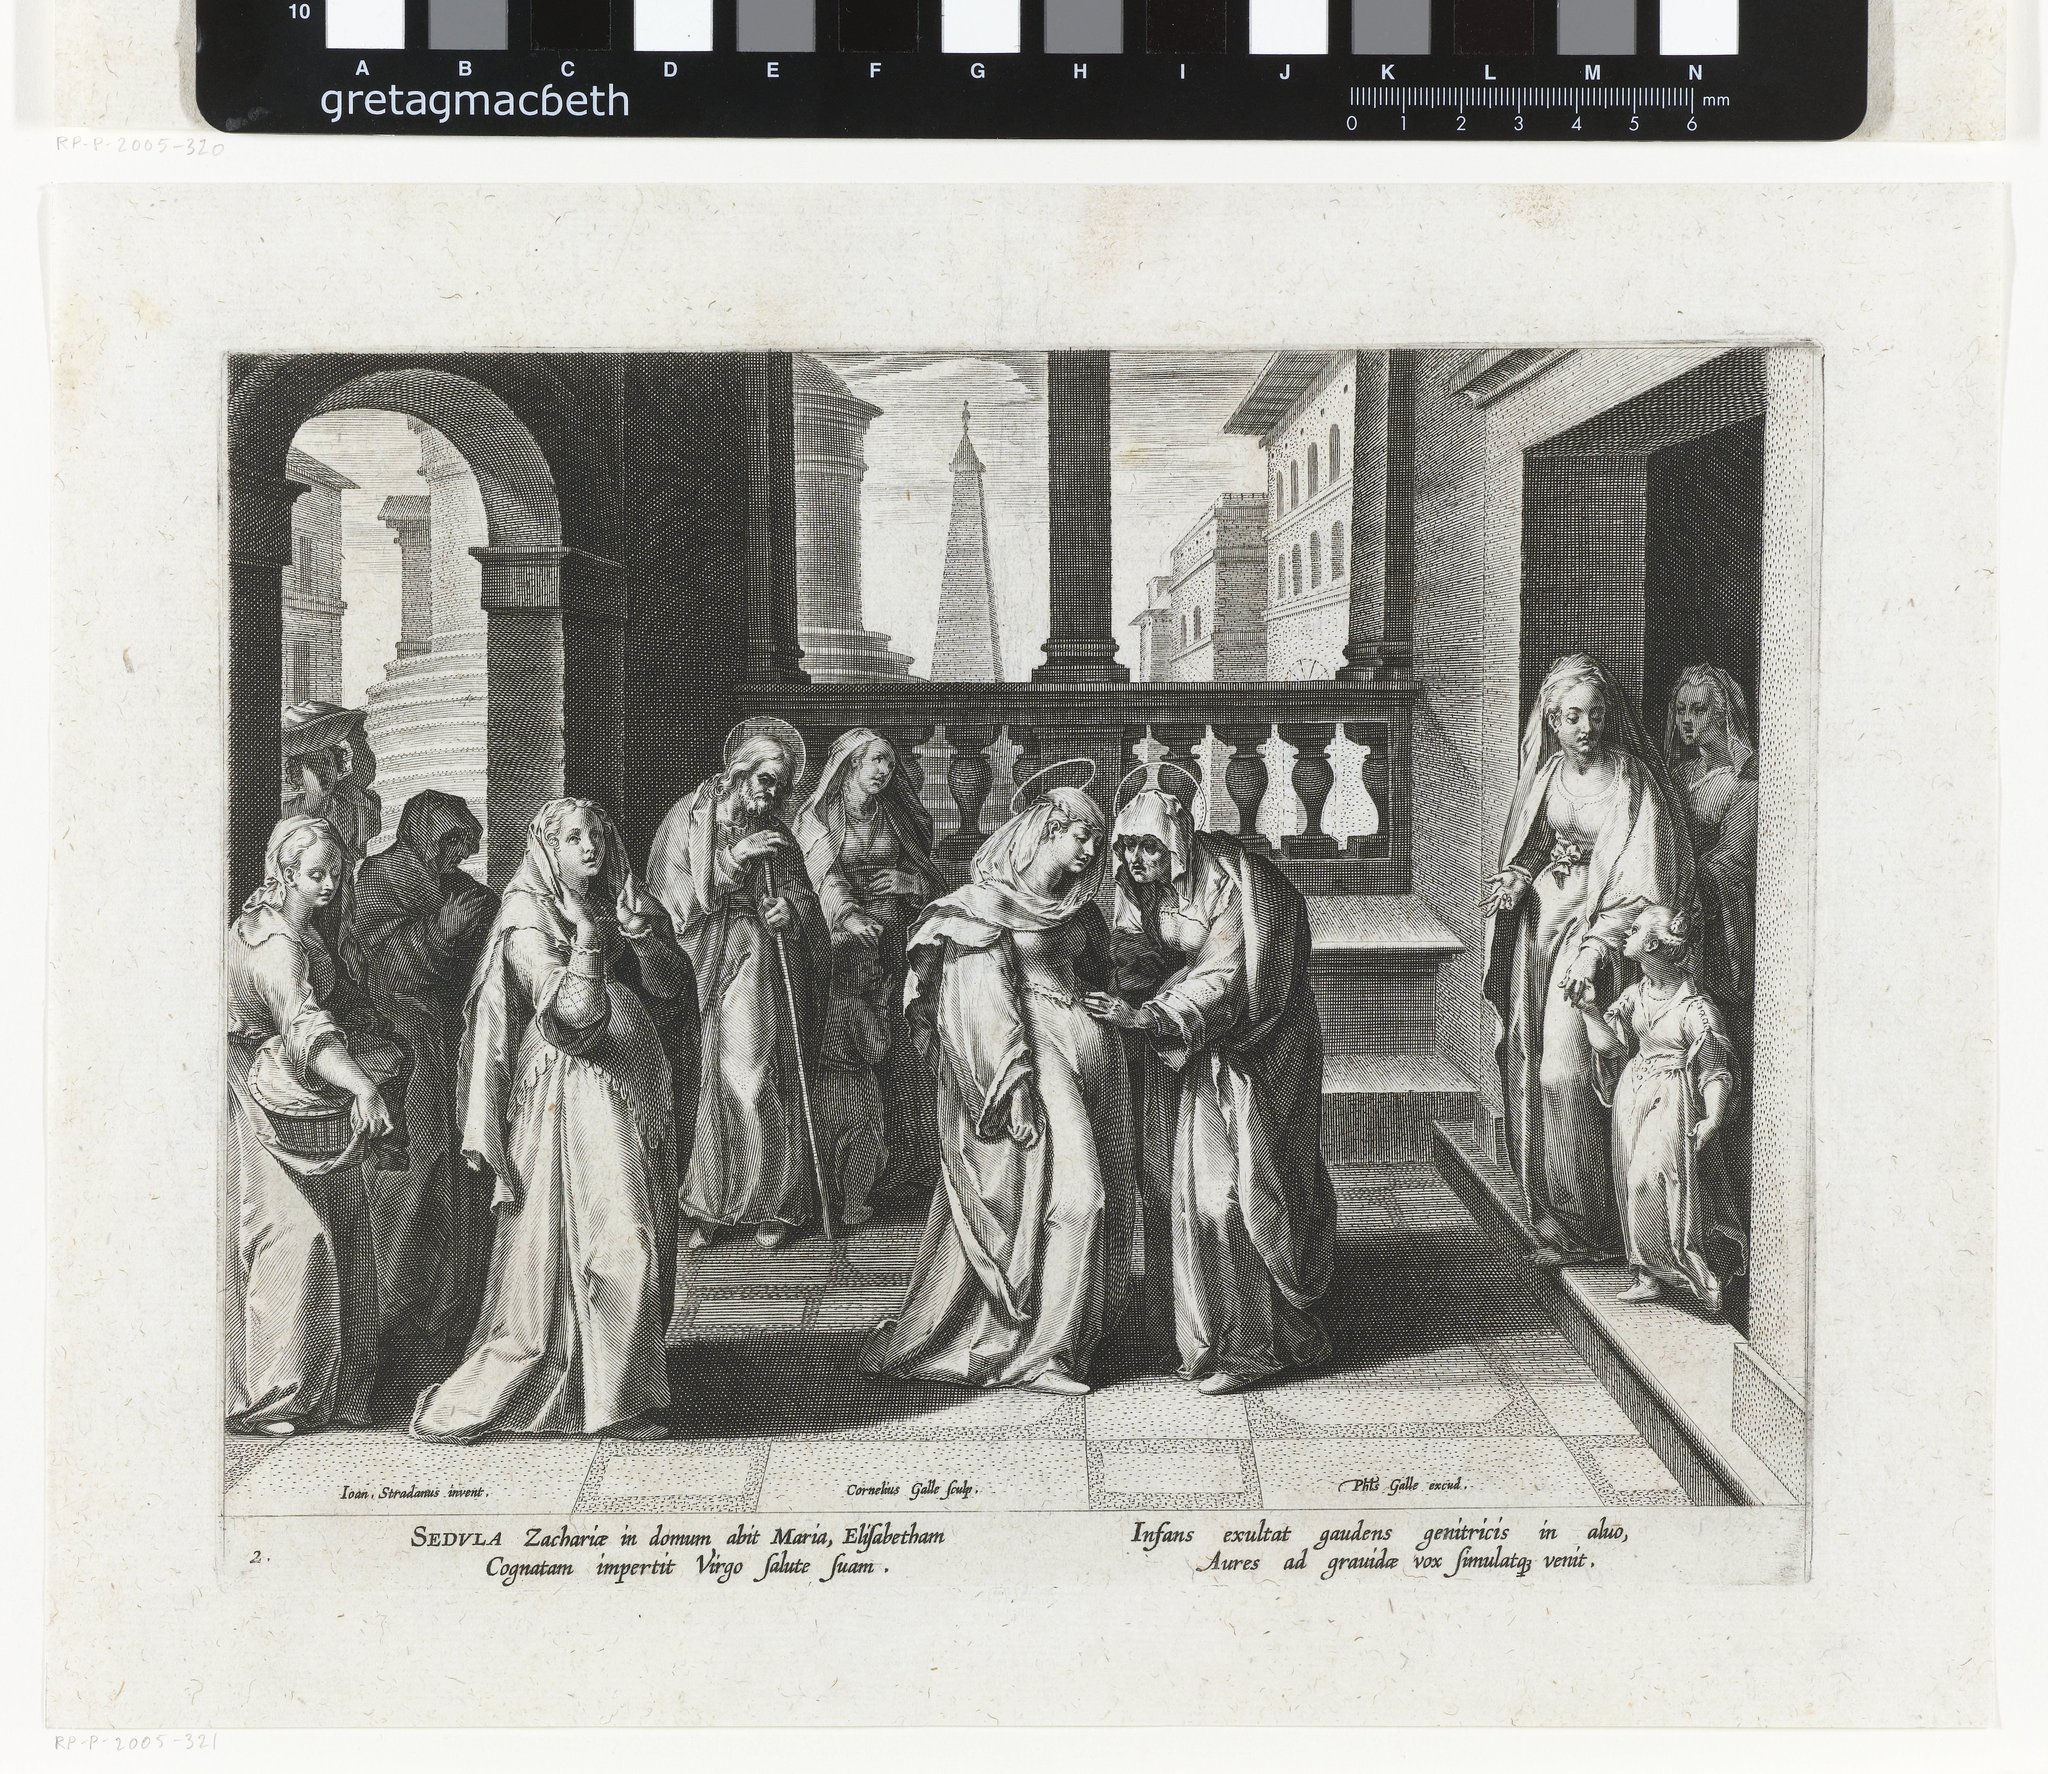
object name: print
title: Het leven van Johannes de Doper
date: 1595-1612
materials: paper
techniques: engraving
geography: southern netherlands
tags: mary and elisabeth, both pregnant, embracing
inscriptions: caption: ‘SEDULA Zachariae in domum abit Maria....vox simulatq[ ] venit.’, collector's mark: Lugt 2228, number: ‘2’, collector's mark: Lugt 2760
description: Maria en Elisabet ontmoeten en omhelzen elkaar in een voorportaal van een huis. Elisabet ziet de zwangerschap van Maria. Linksachter staat Zacharias tussen een groepje vrouwen. Onder de voorstelling een Latijns vers.